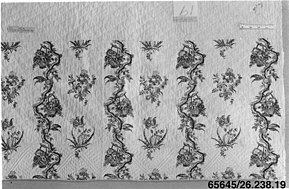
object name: fragment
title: Skirt fragment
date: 1701-1800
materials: cotton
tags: flowers